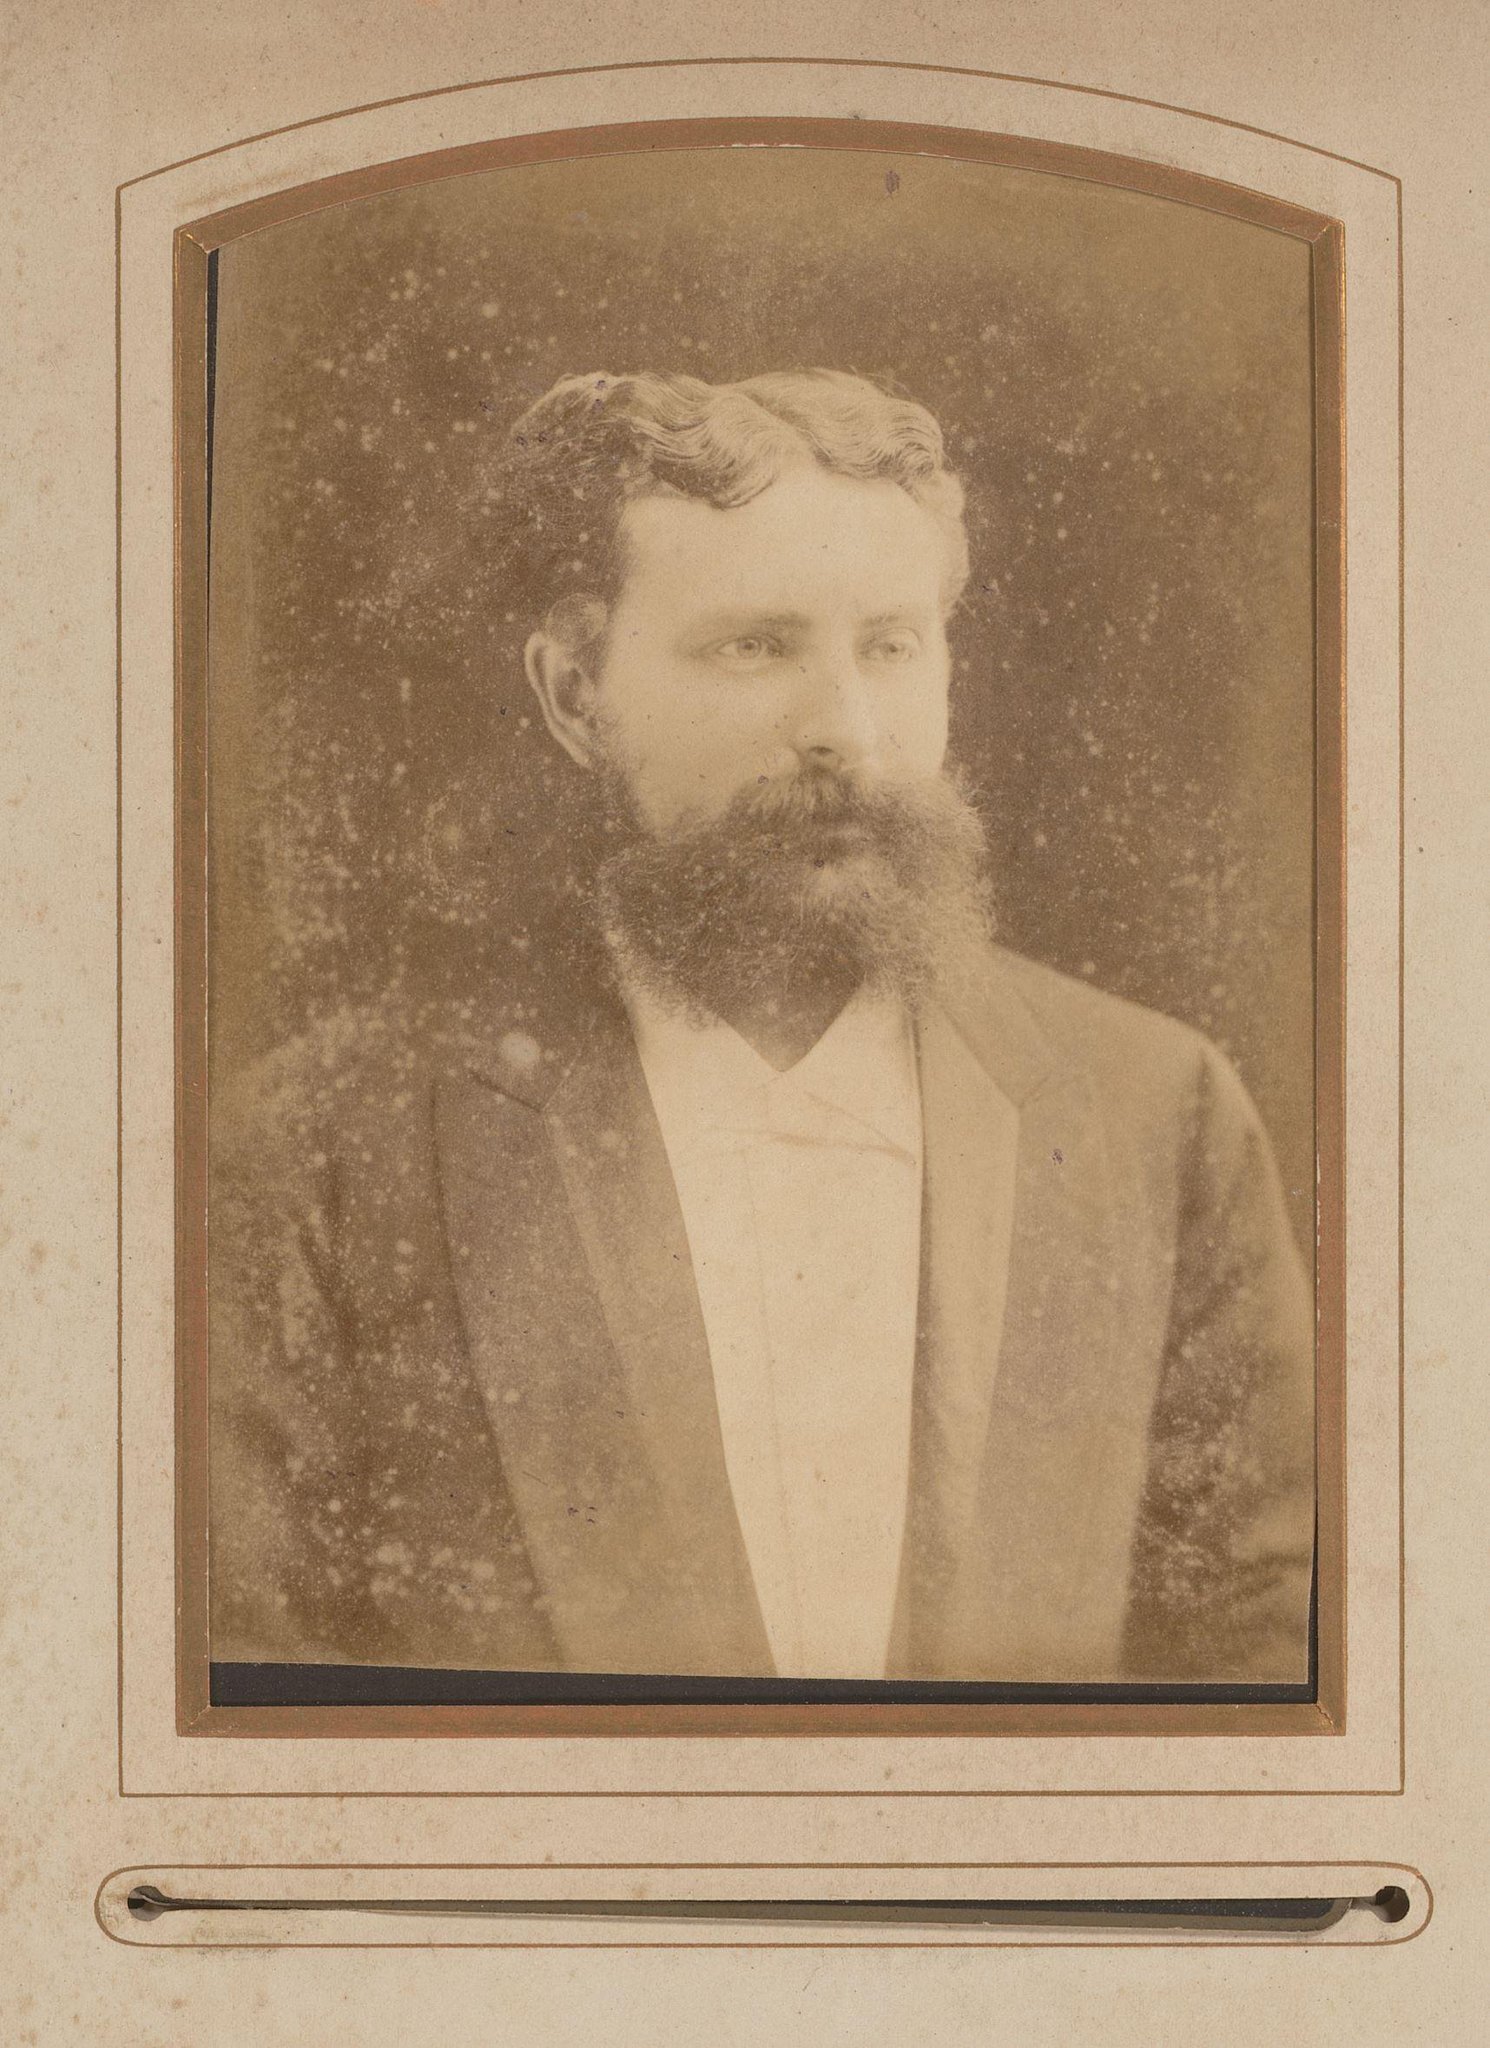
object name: photograph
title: Portret van een man met snor en baard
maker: herman salzwedel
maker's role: fotograaf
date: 1880-1905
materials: cardboard, photographic support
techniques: albumen print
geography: surabaya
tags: moustache, historical persons, beard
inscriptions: inscription: ‘CABINET-PORTRET/ Salzwedel & Co./ Soerabaya.’